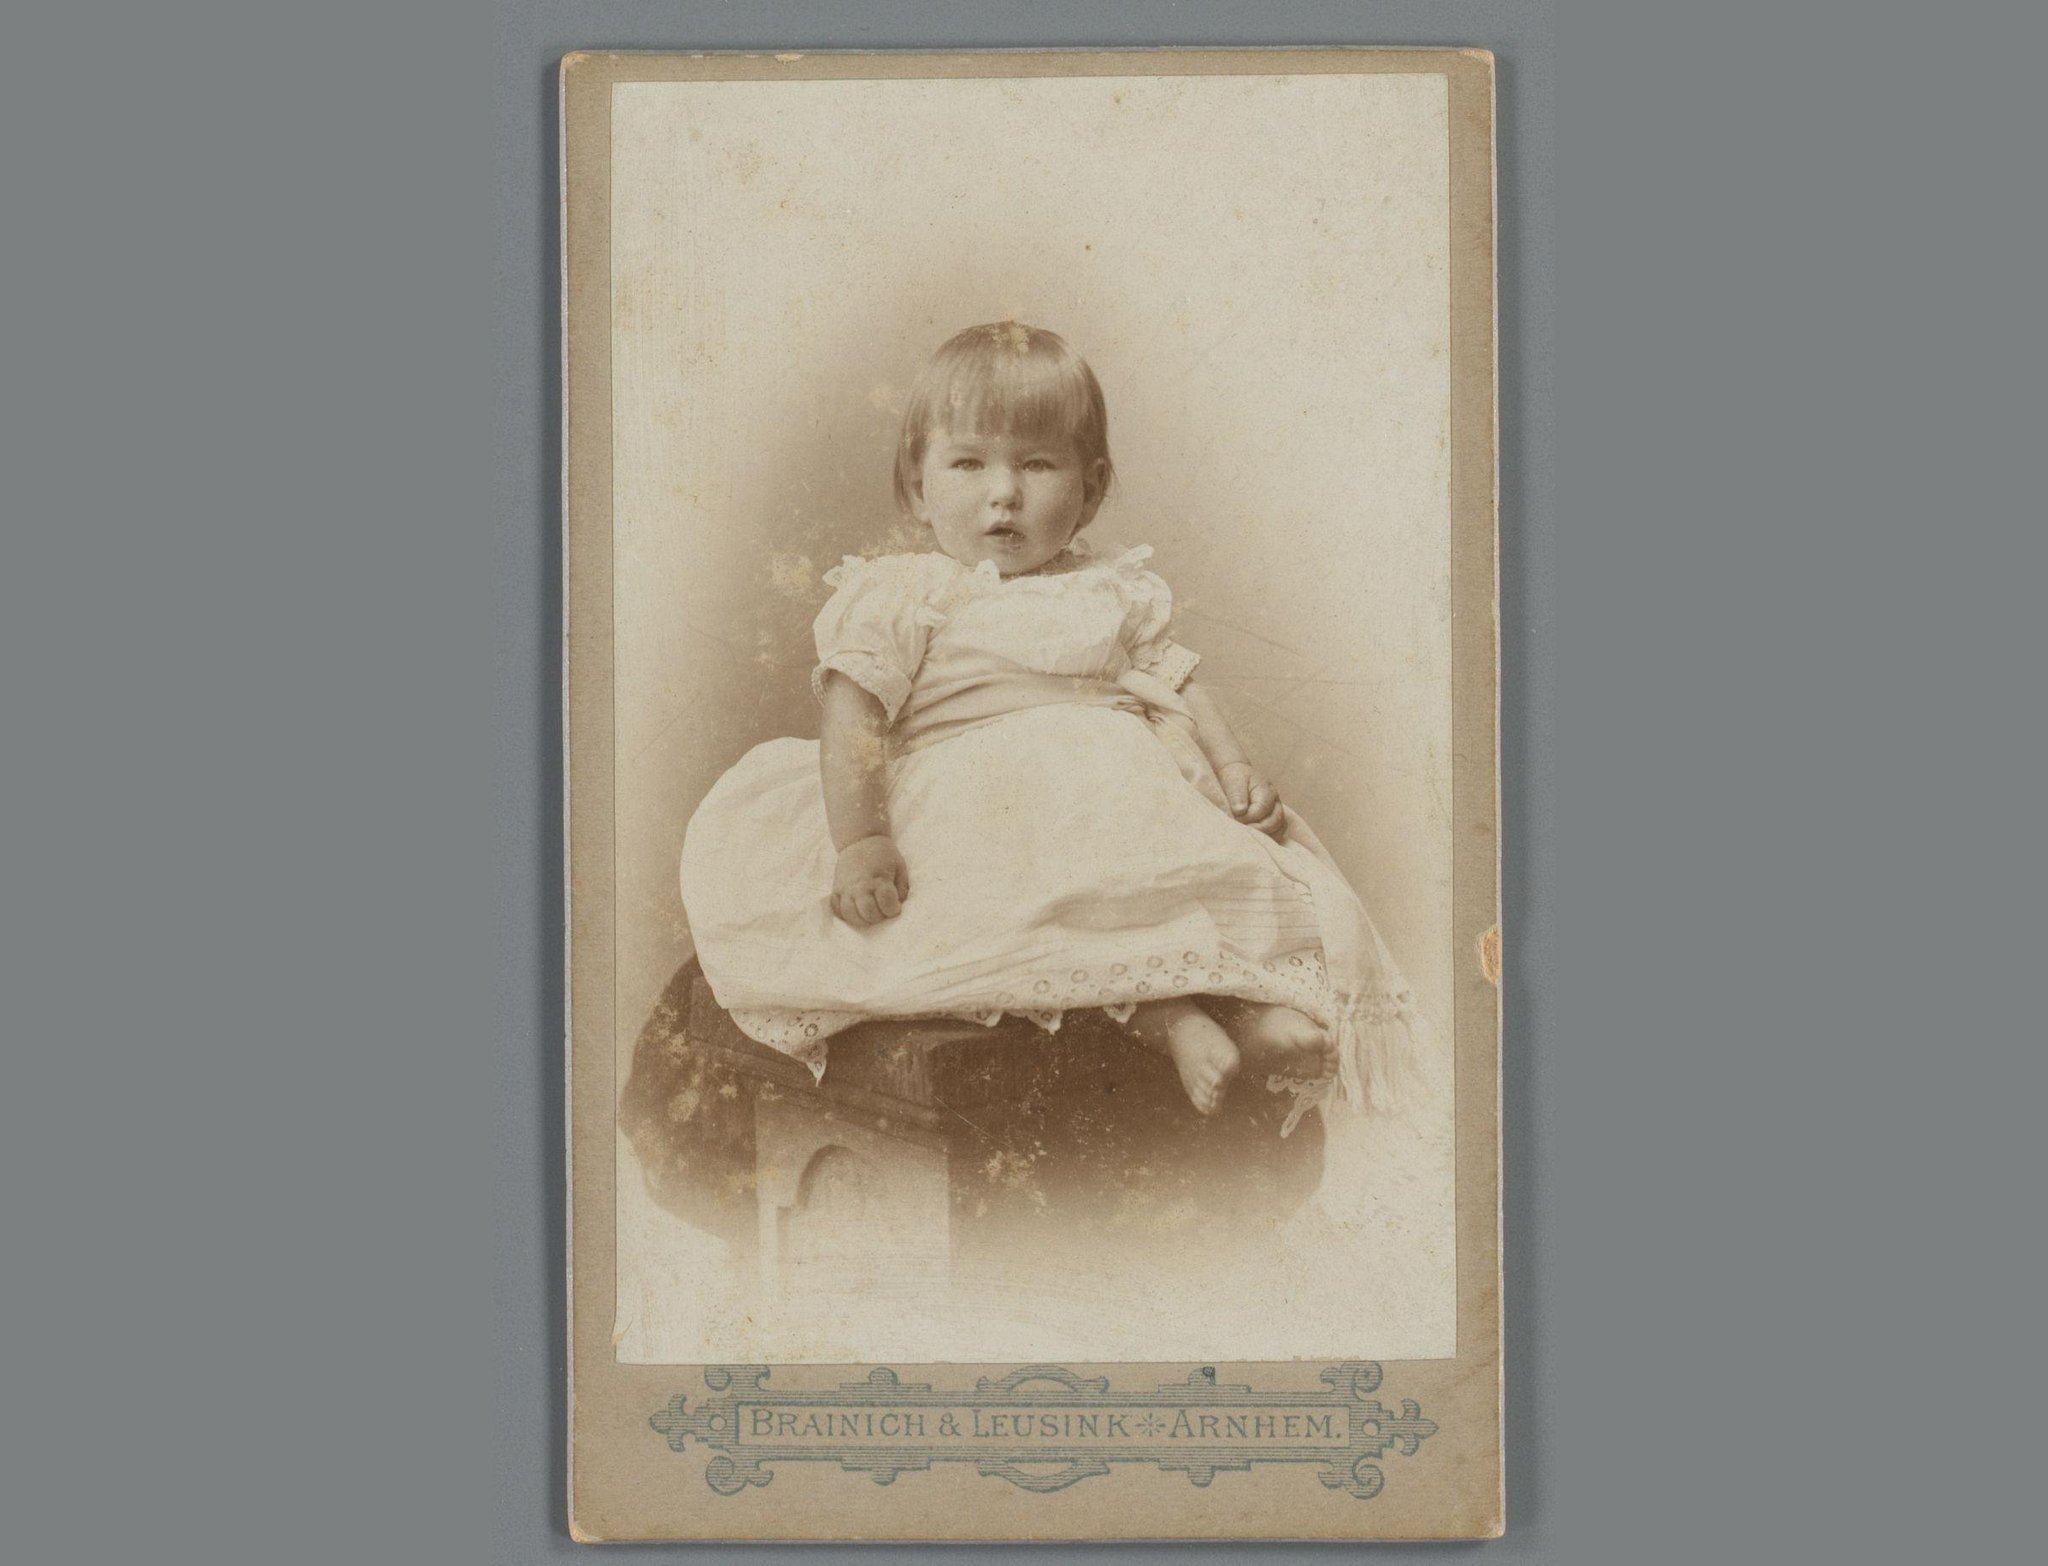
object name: photograph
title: Portret van een onbekend kind uit de familie en de kring van Eugene van Delden en Belle van Delden-Denninghof Stelling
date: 1881-1904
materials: paper, cardboard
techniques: gelatin silver print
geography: arnhem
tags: infant, baby, historical persons not known by name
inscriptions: inscription: ‘BRAINICH & LEUSINK/ Photogr. Atelier/ Arnhem Menthenstraat No. 10./ Vergrootingen naar/ ieder klein portret./ De platen blijven voor/ nabestelling bewaard.’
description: Portret uit de kring van Eugene van Delden (Hartapoera, 1865 - Den Haag, 1954) en Belle van Delden-Denninghof Stelling (Batavia, 1870 - Den Haag, 1947).